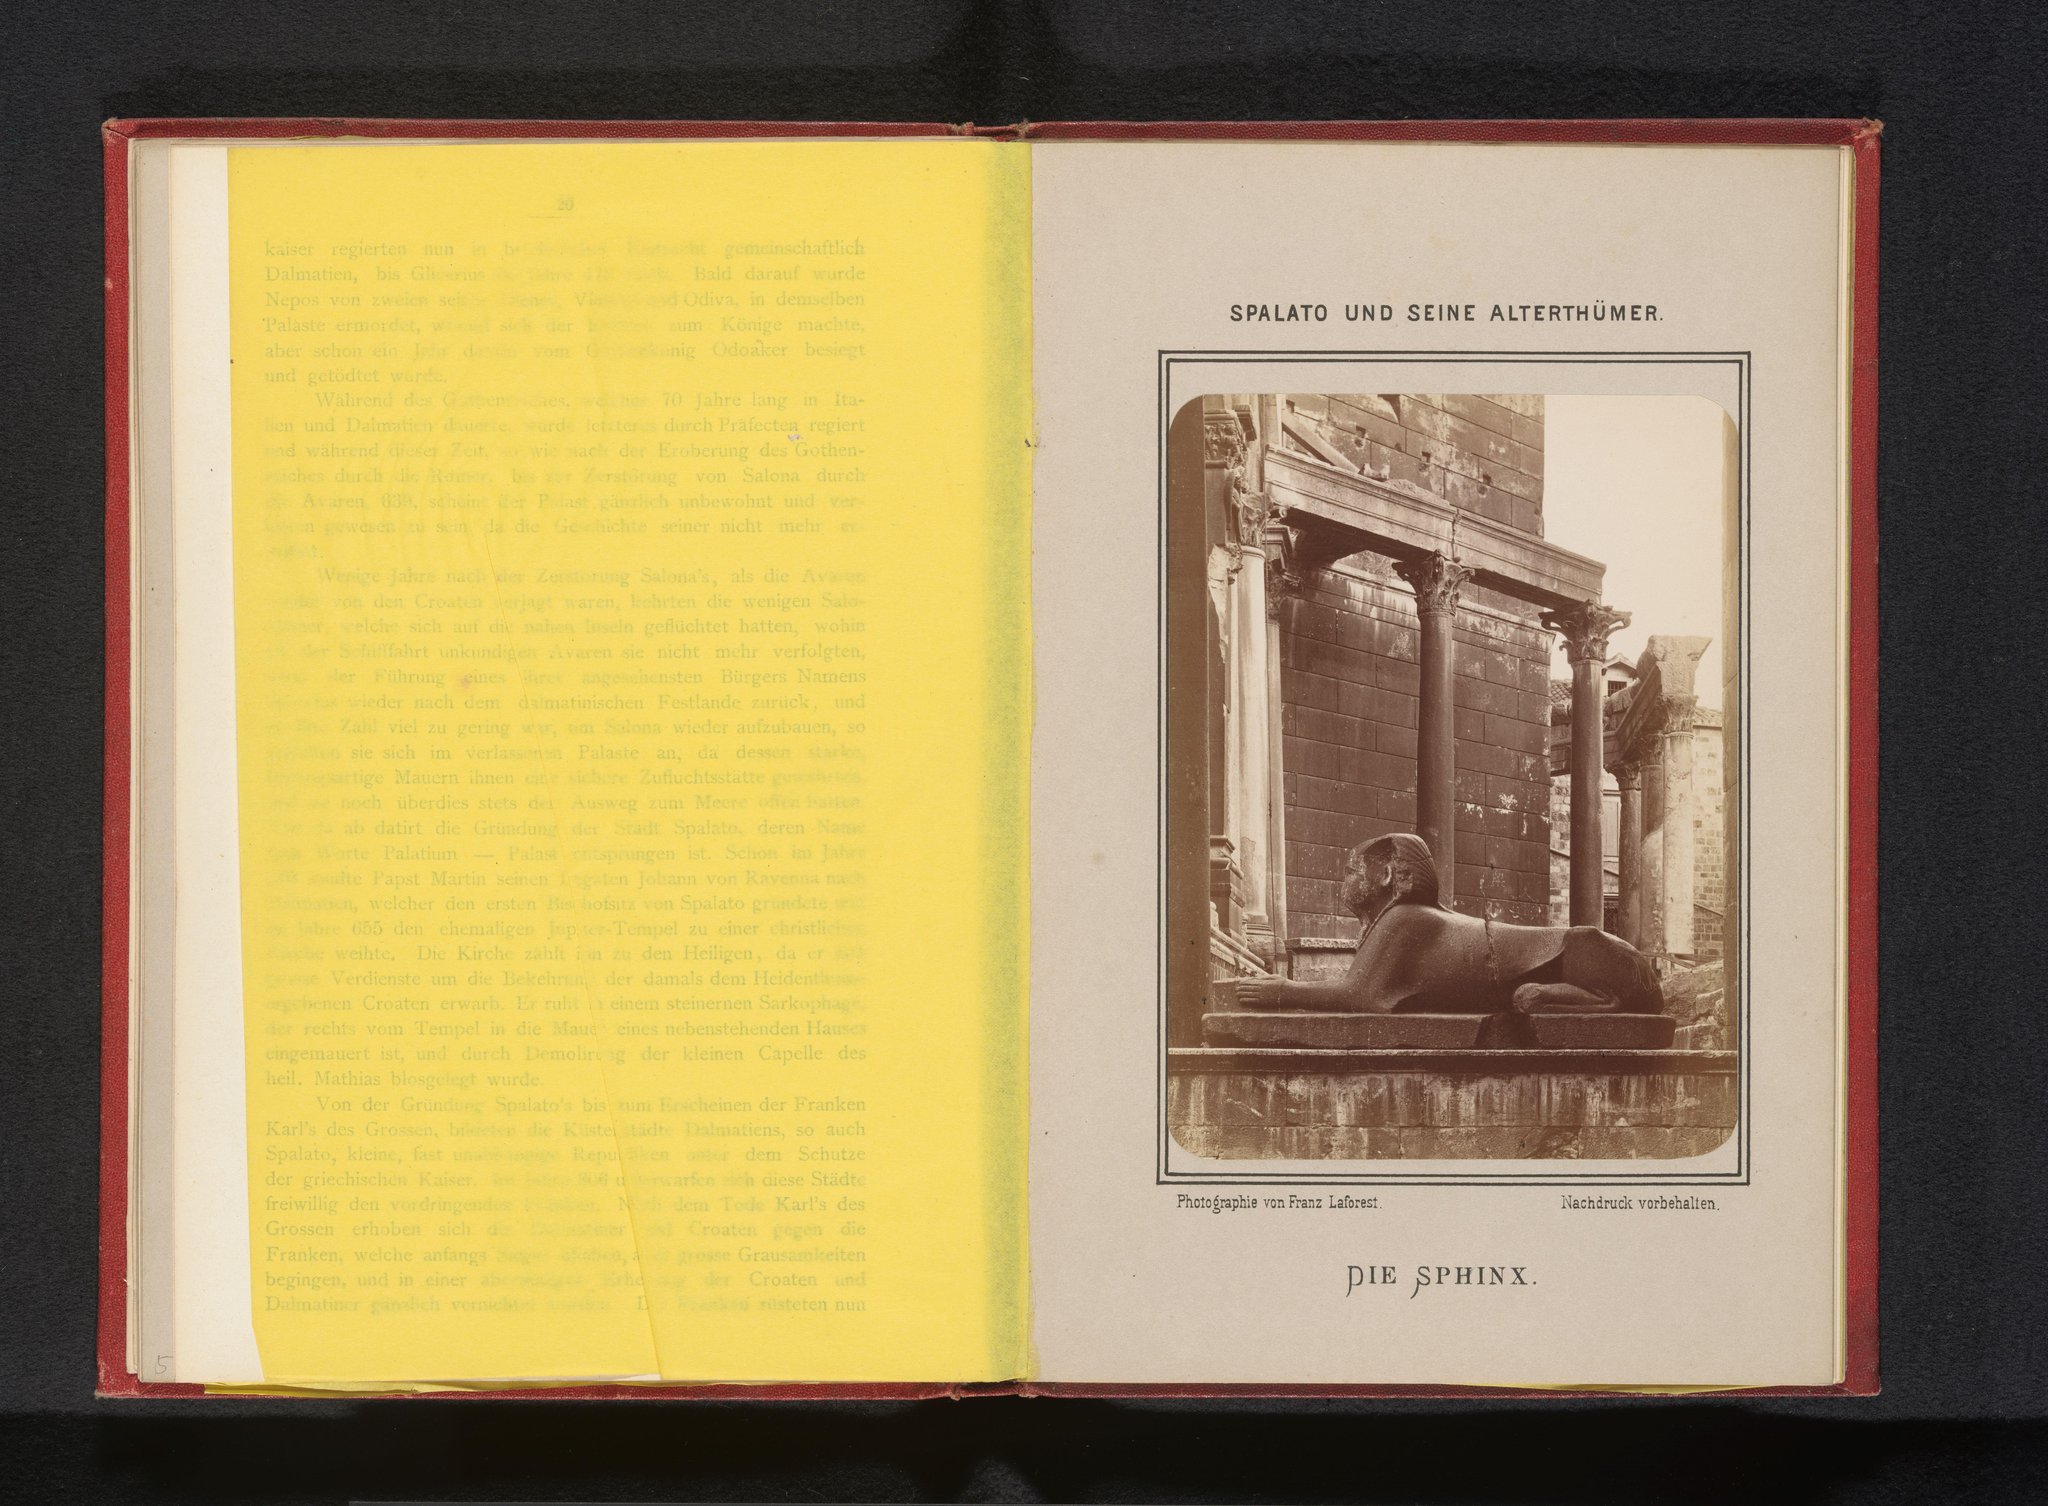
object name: photograph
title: Spalato und seine Alterthümer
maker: franz thiard de laforest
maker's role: fotograaf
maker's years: 1838-1911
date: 1868-1878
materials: photographic support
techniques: albumen print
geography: split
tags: sphinx (lion/woman); 'sfinge' (ripa), sculpture